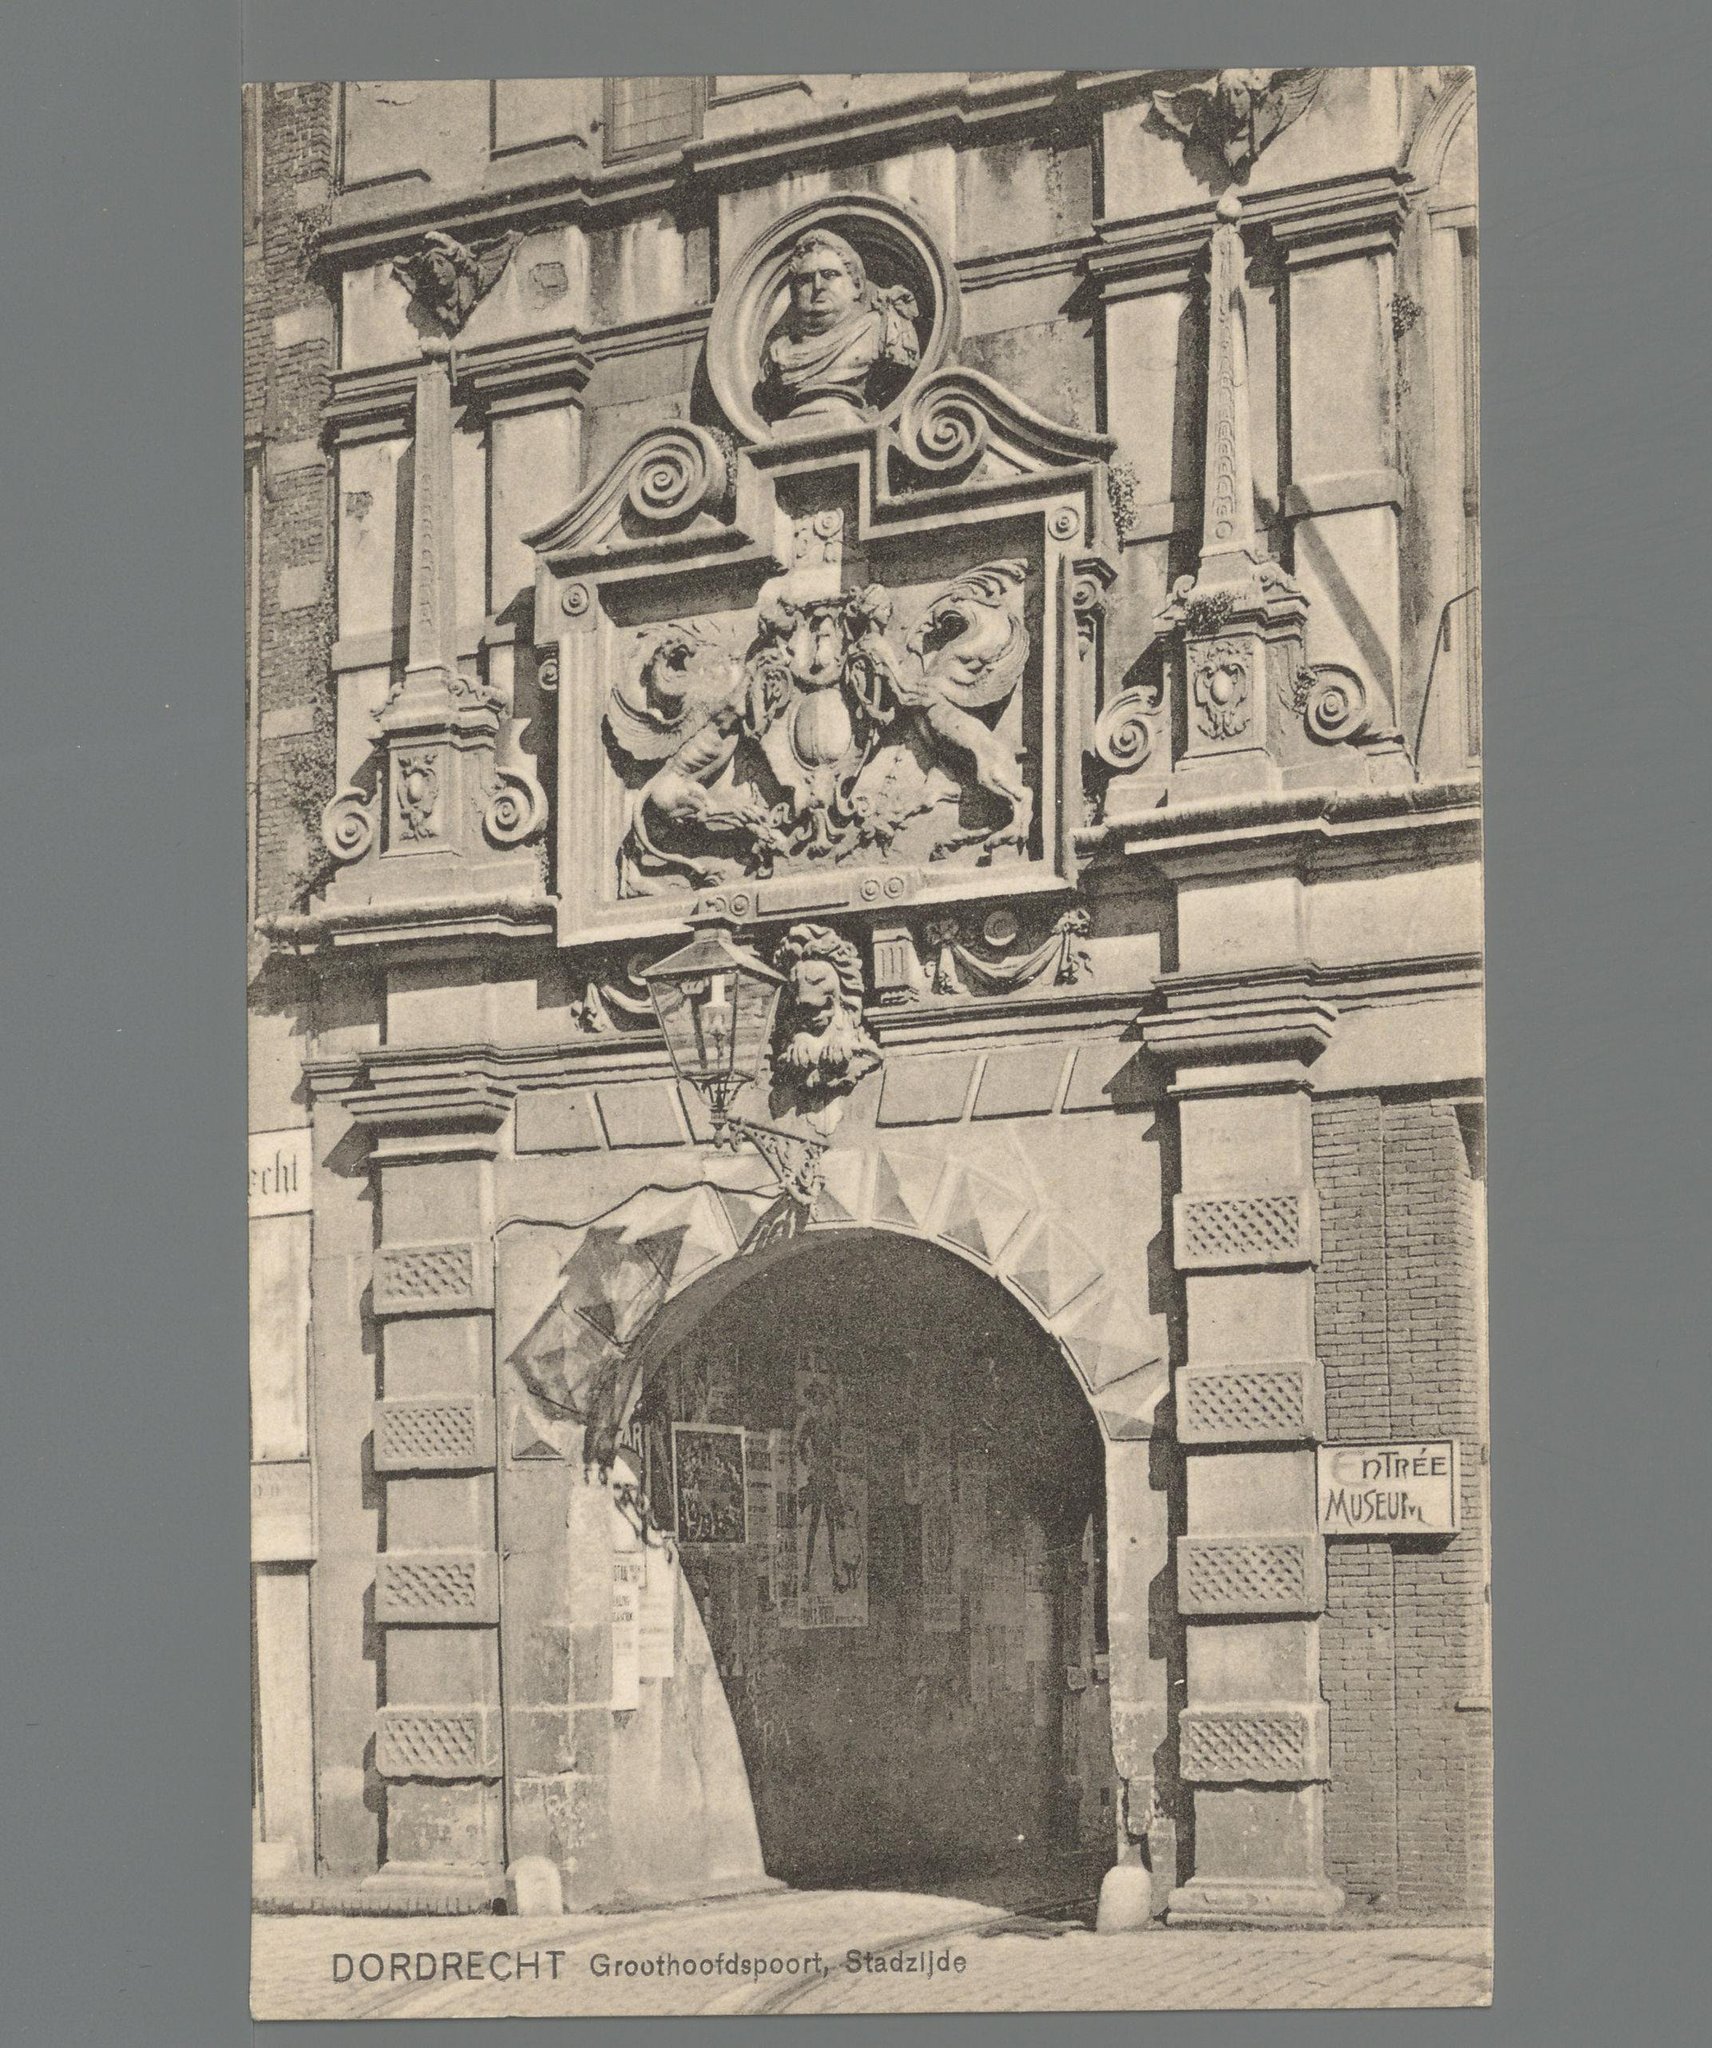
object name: photomechanical print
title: Dordrecht. Groothoofdspoort, stadzijde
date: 1905-1930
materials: cardboard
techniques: photograph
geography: dordrecht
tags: permanent exhibition, museum, city-gate